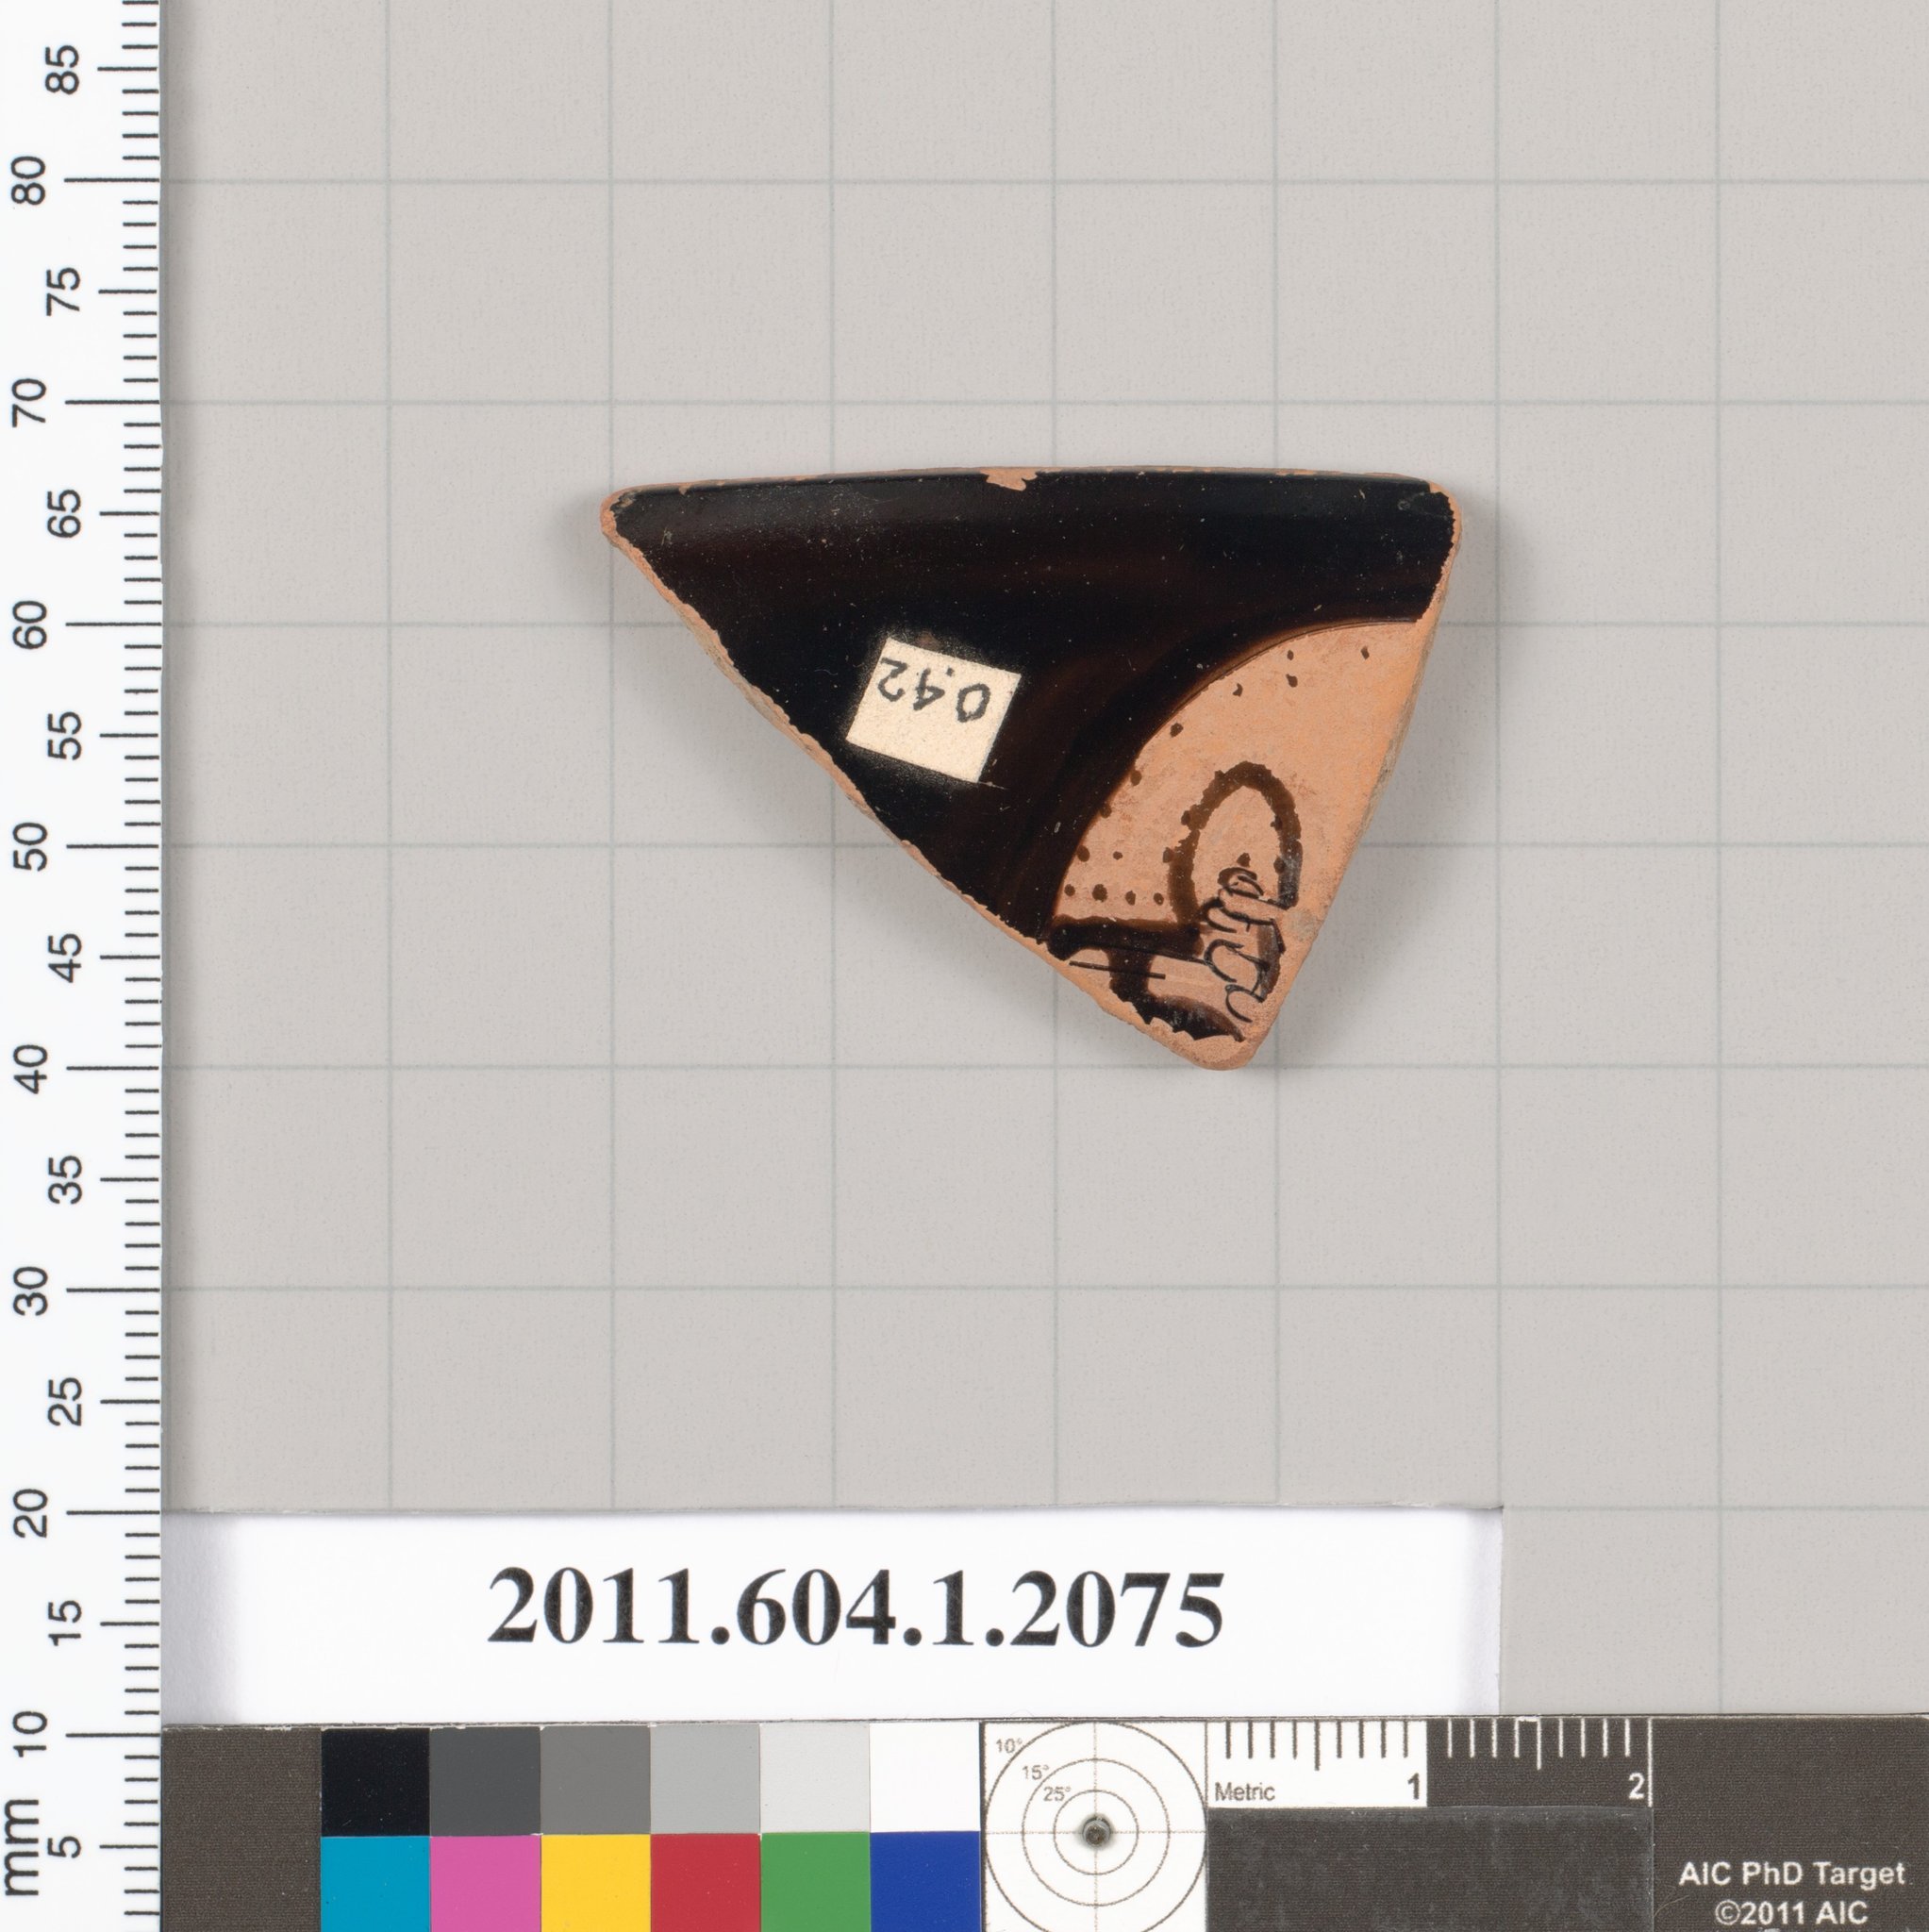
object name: kylix fragment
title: Terracotta rim fragment of a kylix (drinking cup)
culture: greek, attic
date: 490-480 BCE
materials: terracotta